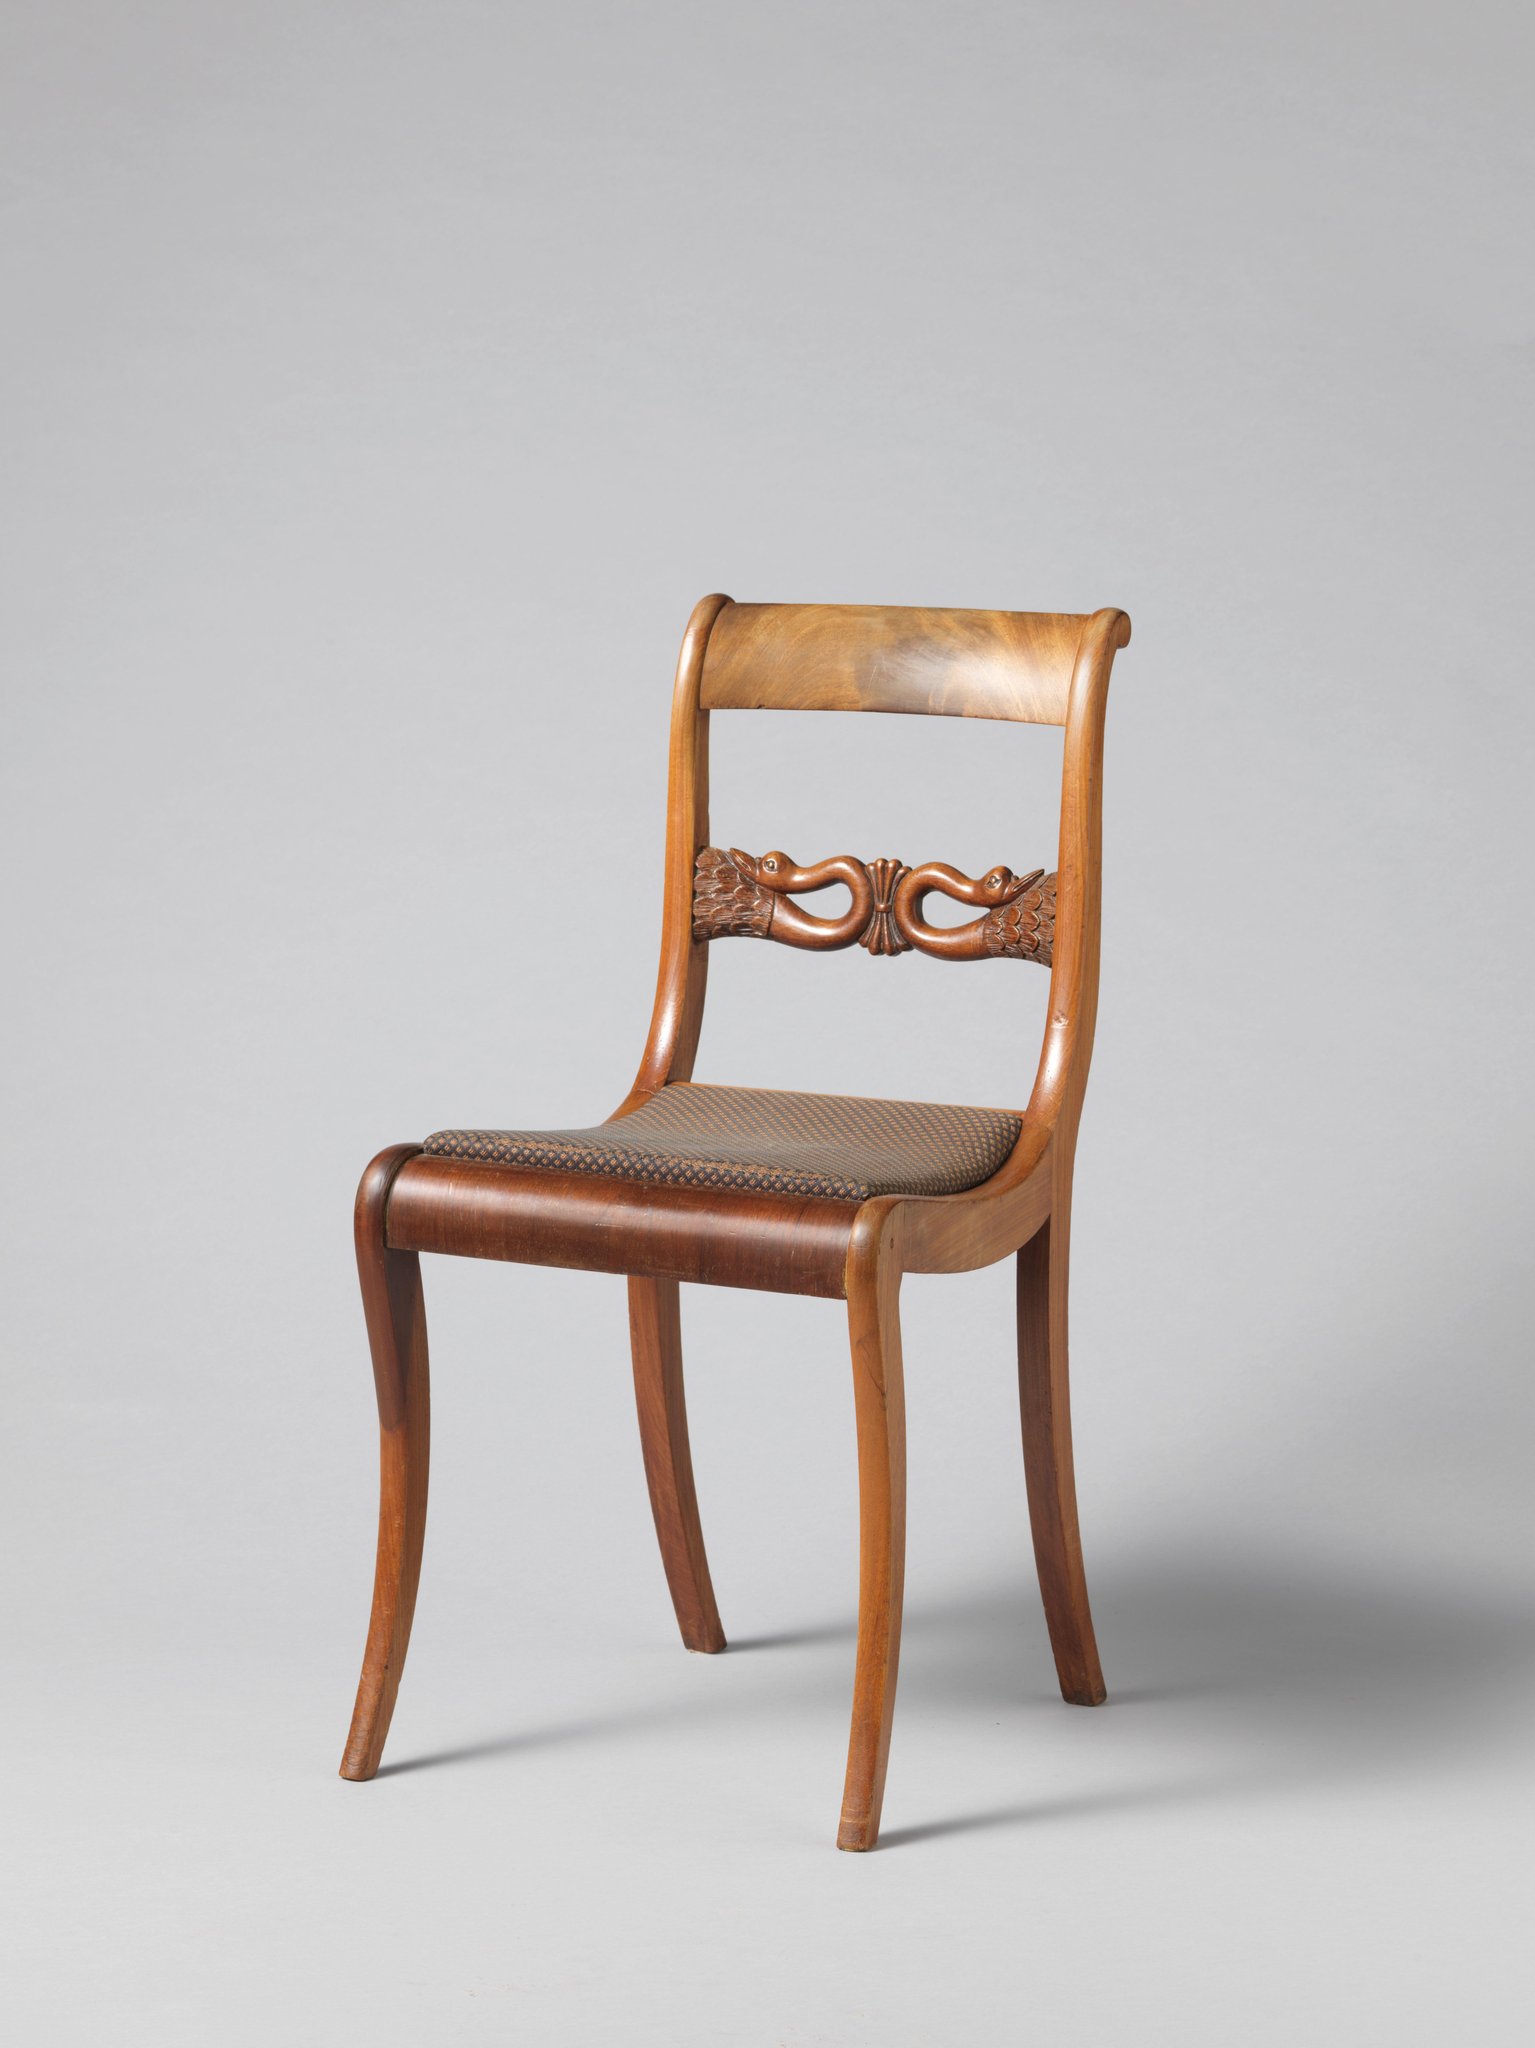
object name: furniture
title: Stoel met zwanen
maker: Anonymous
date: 1830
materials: wood, textile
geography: netherlands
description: Stoel uit een set van tien stoelen en vier armstoelen van deels massief en deels belijmd mahoniehout op iepenhouten kern. Losse beklede zittingen. De vierkante achterpoten wijken achterwaarts. Negen stoelen en een armstoel hebben vierkante, aan de voorzijde iets afgeronde, voorpoten; de rest heeft ronde gelede voorpoten. De gestrekt S-vormige ruggen hebben een gebeeldhouwde tussenregel met een palmet geflankeerd door twee toegewende, met de halzen terugbuigende zwanen. De platte voluutvormige armleggers lopen hoog in de rug over.